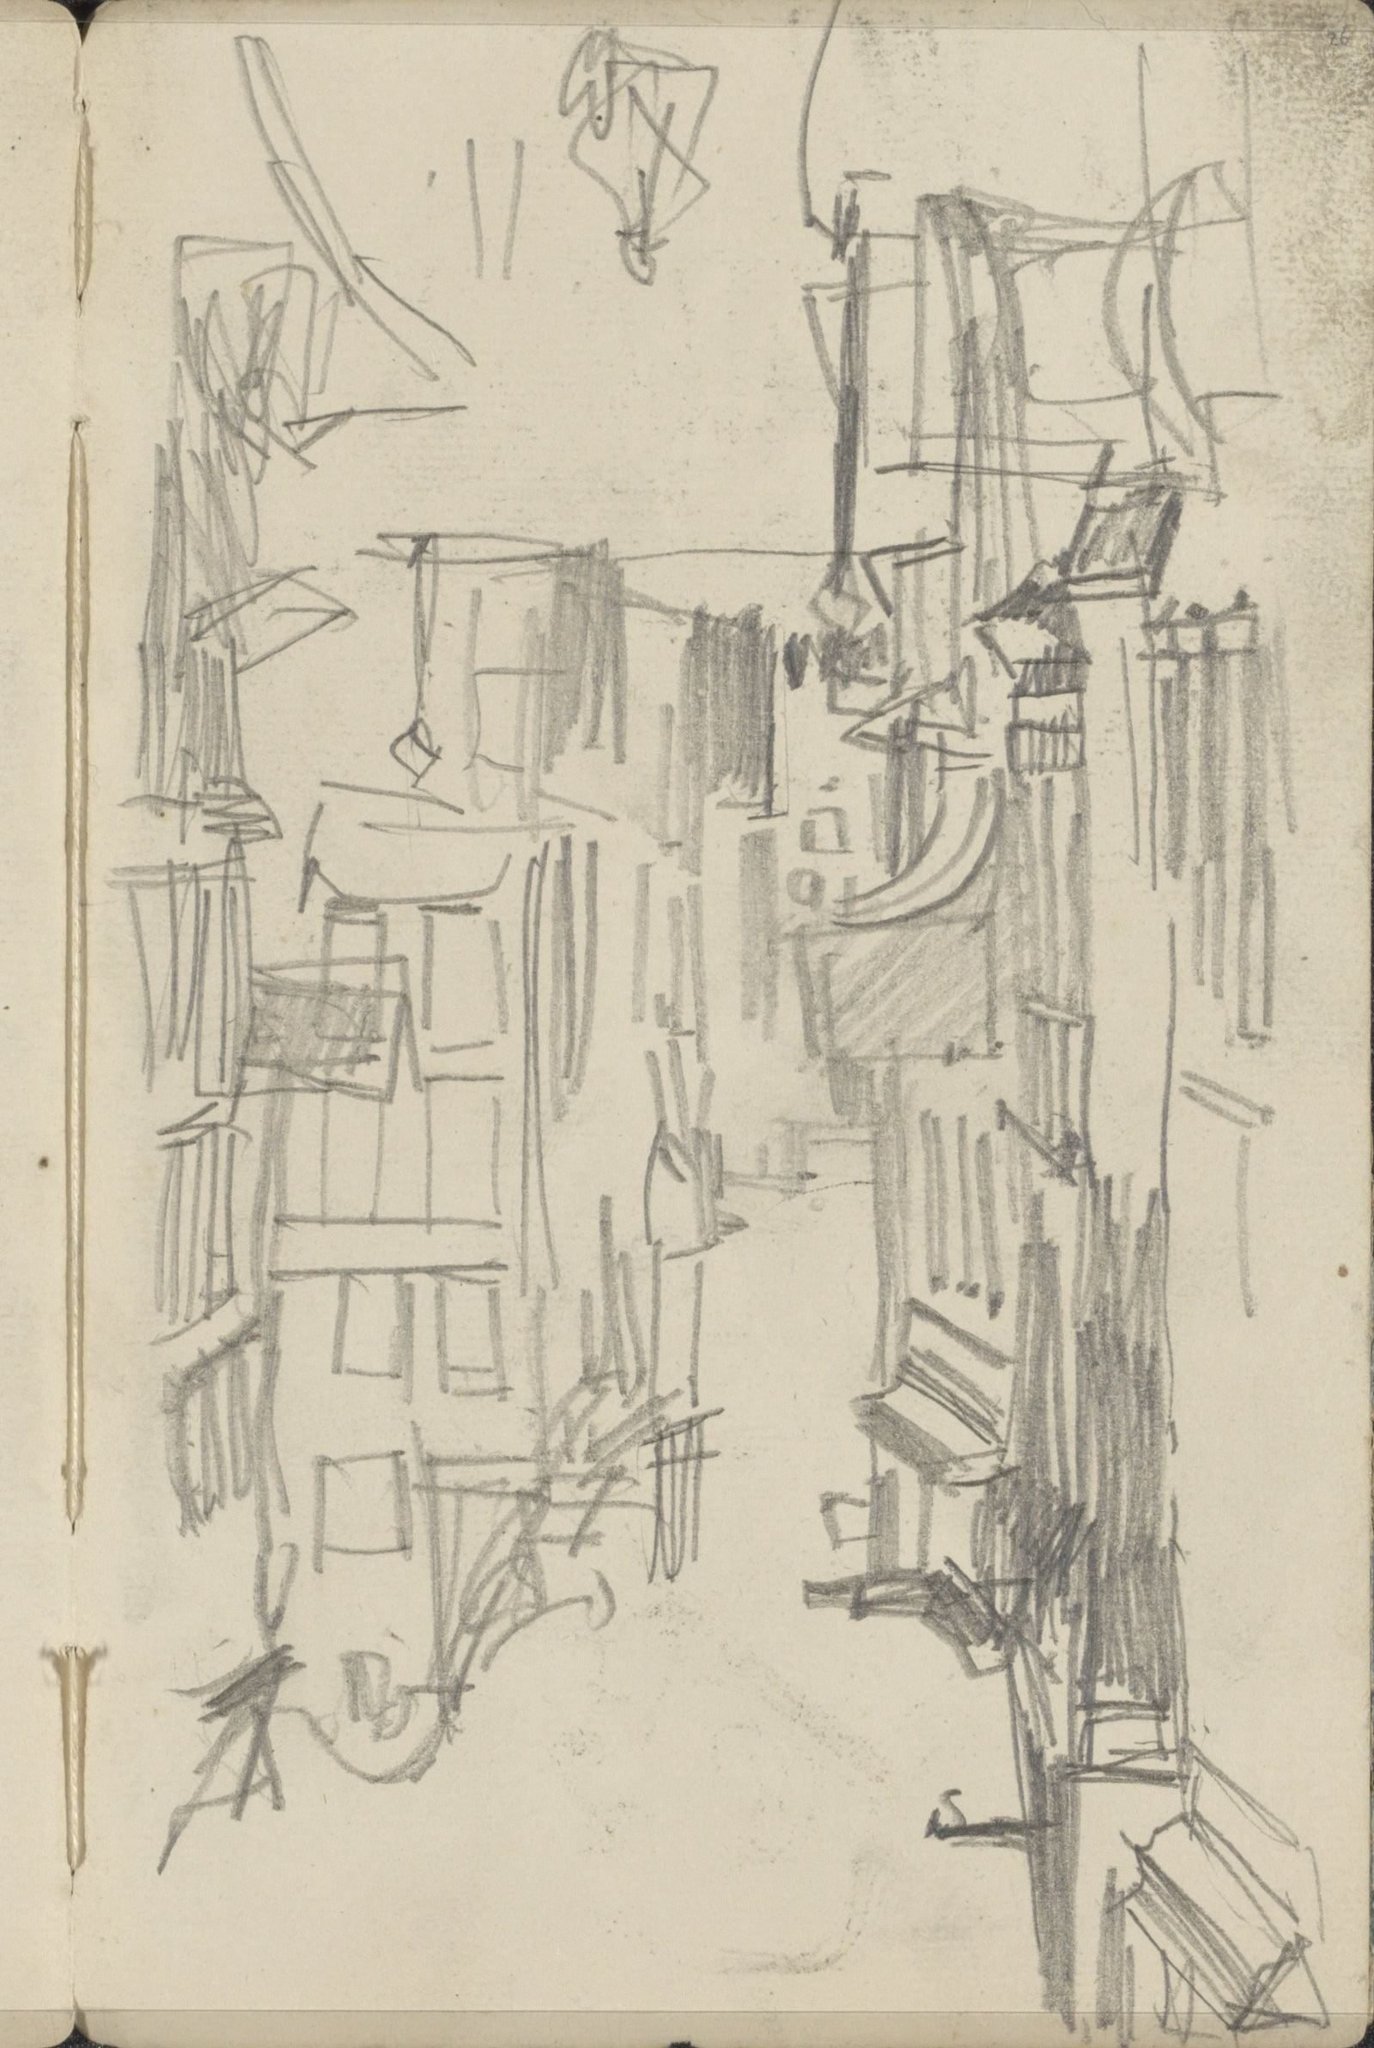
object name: sketchbook leaf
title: Gezicht op een straat in Amsterdam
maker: george hendrik breitner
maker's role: draughtsman, painter, print maker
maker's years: 1857-1923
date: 1887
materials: paper, pencil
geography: amsterdam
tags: civic architecture; edifices; dwellings, street (+ city(-scape) with figures, staffage), amsterdam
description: Pagina 26 uit een schetsboek met 12 bladen.